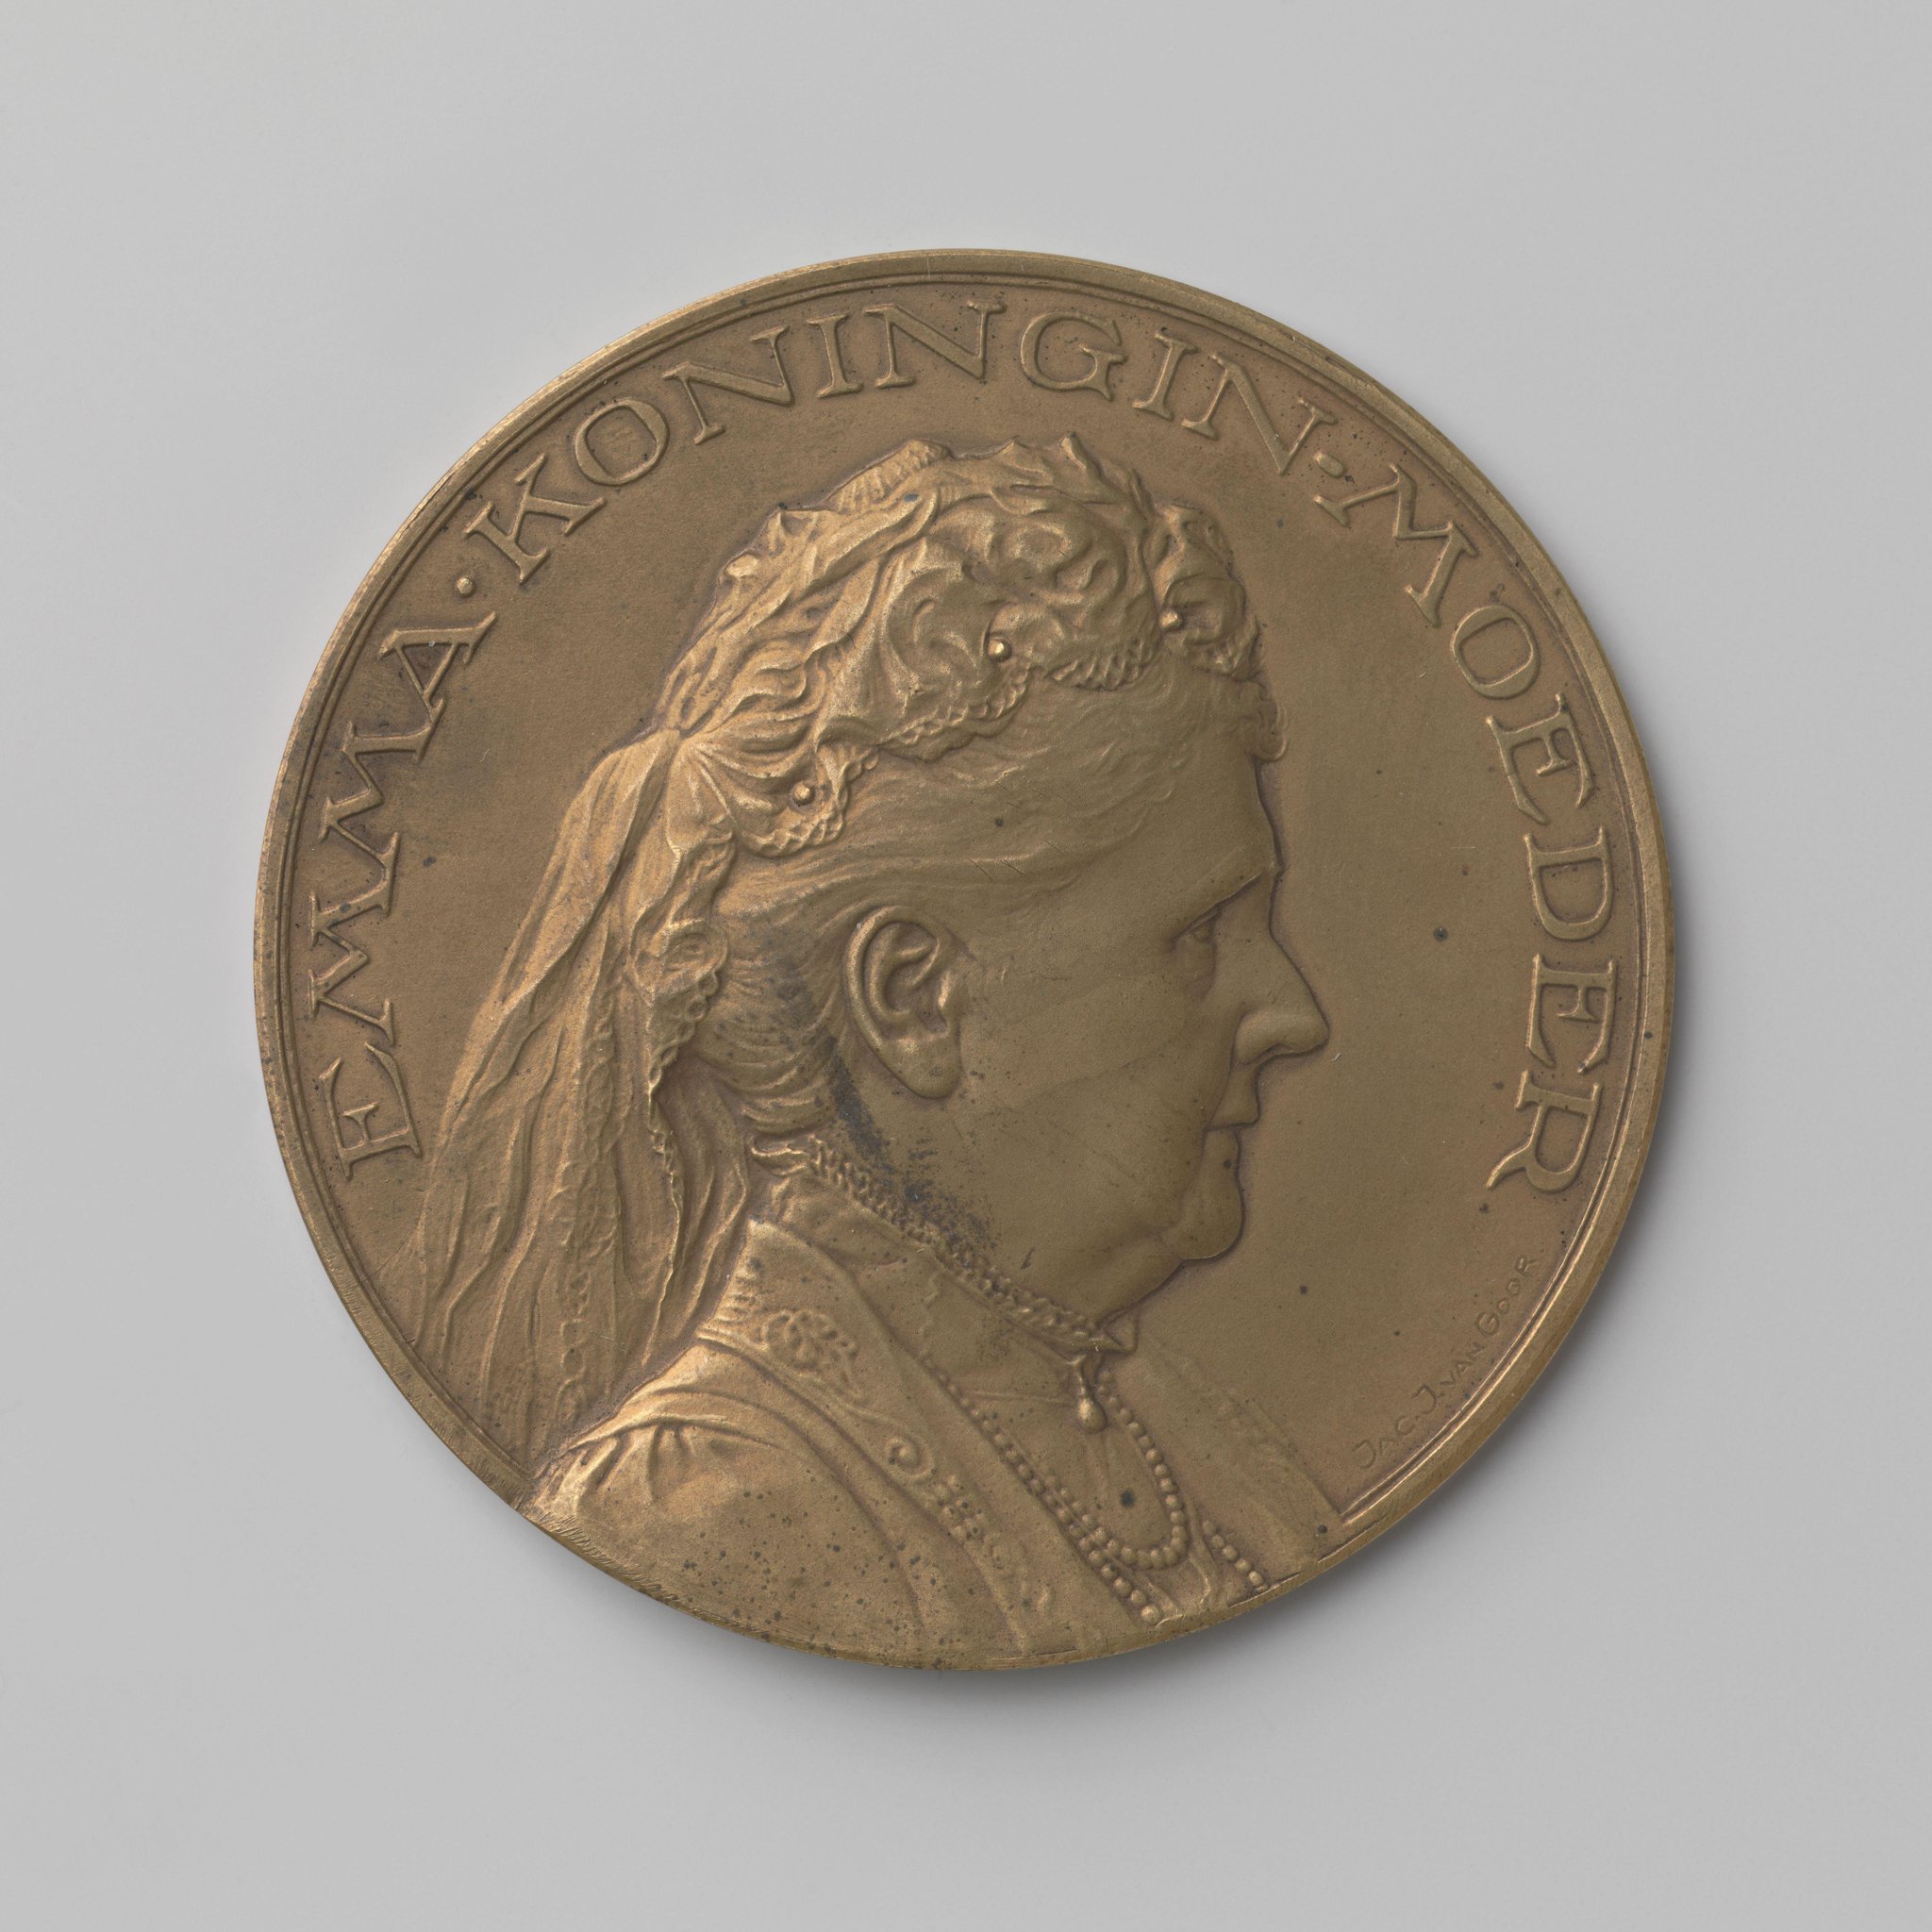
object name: history medal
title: Zeventigste verjaardag van Koningin Emma 1928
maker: jacob jan van goor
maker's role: medailleur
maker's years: 1874-1956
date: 1928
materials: bronze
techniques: striking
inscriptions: inscription: ‘71’, inscription: ‘A.J. BEMOLT VAN LOGHUM SLATERUS’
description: Bronzen penning, op de voorzijde het borstbeeld van Emma naar rechts met omschrift, op de keerzijde de ovale wapenschilden van Nederland en Emma waartussen oranje- en lauwertakken, met omschrift, met randinscripties 71 en A.J. van Loghum Slaterus.